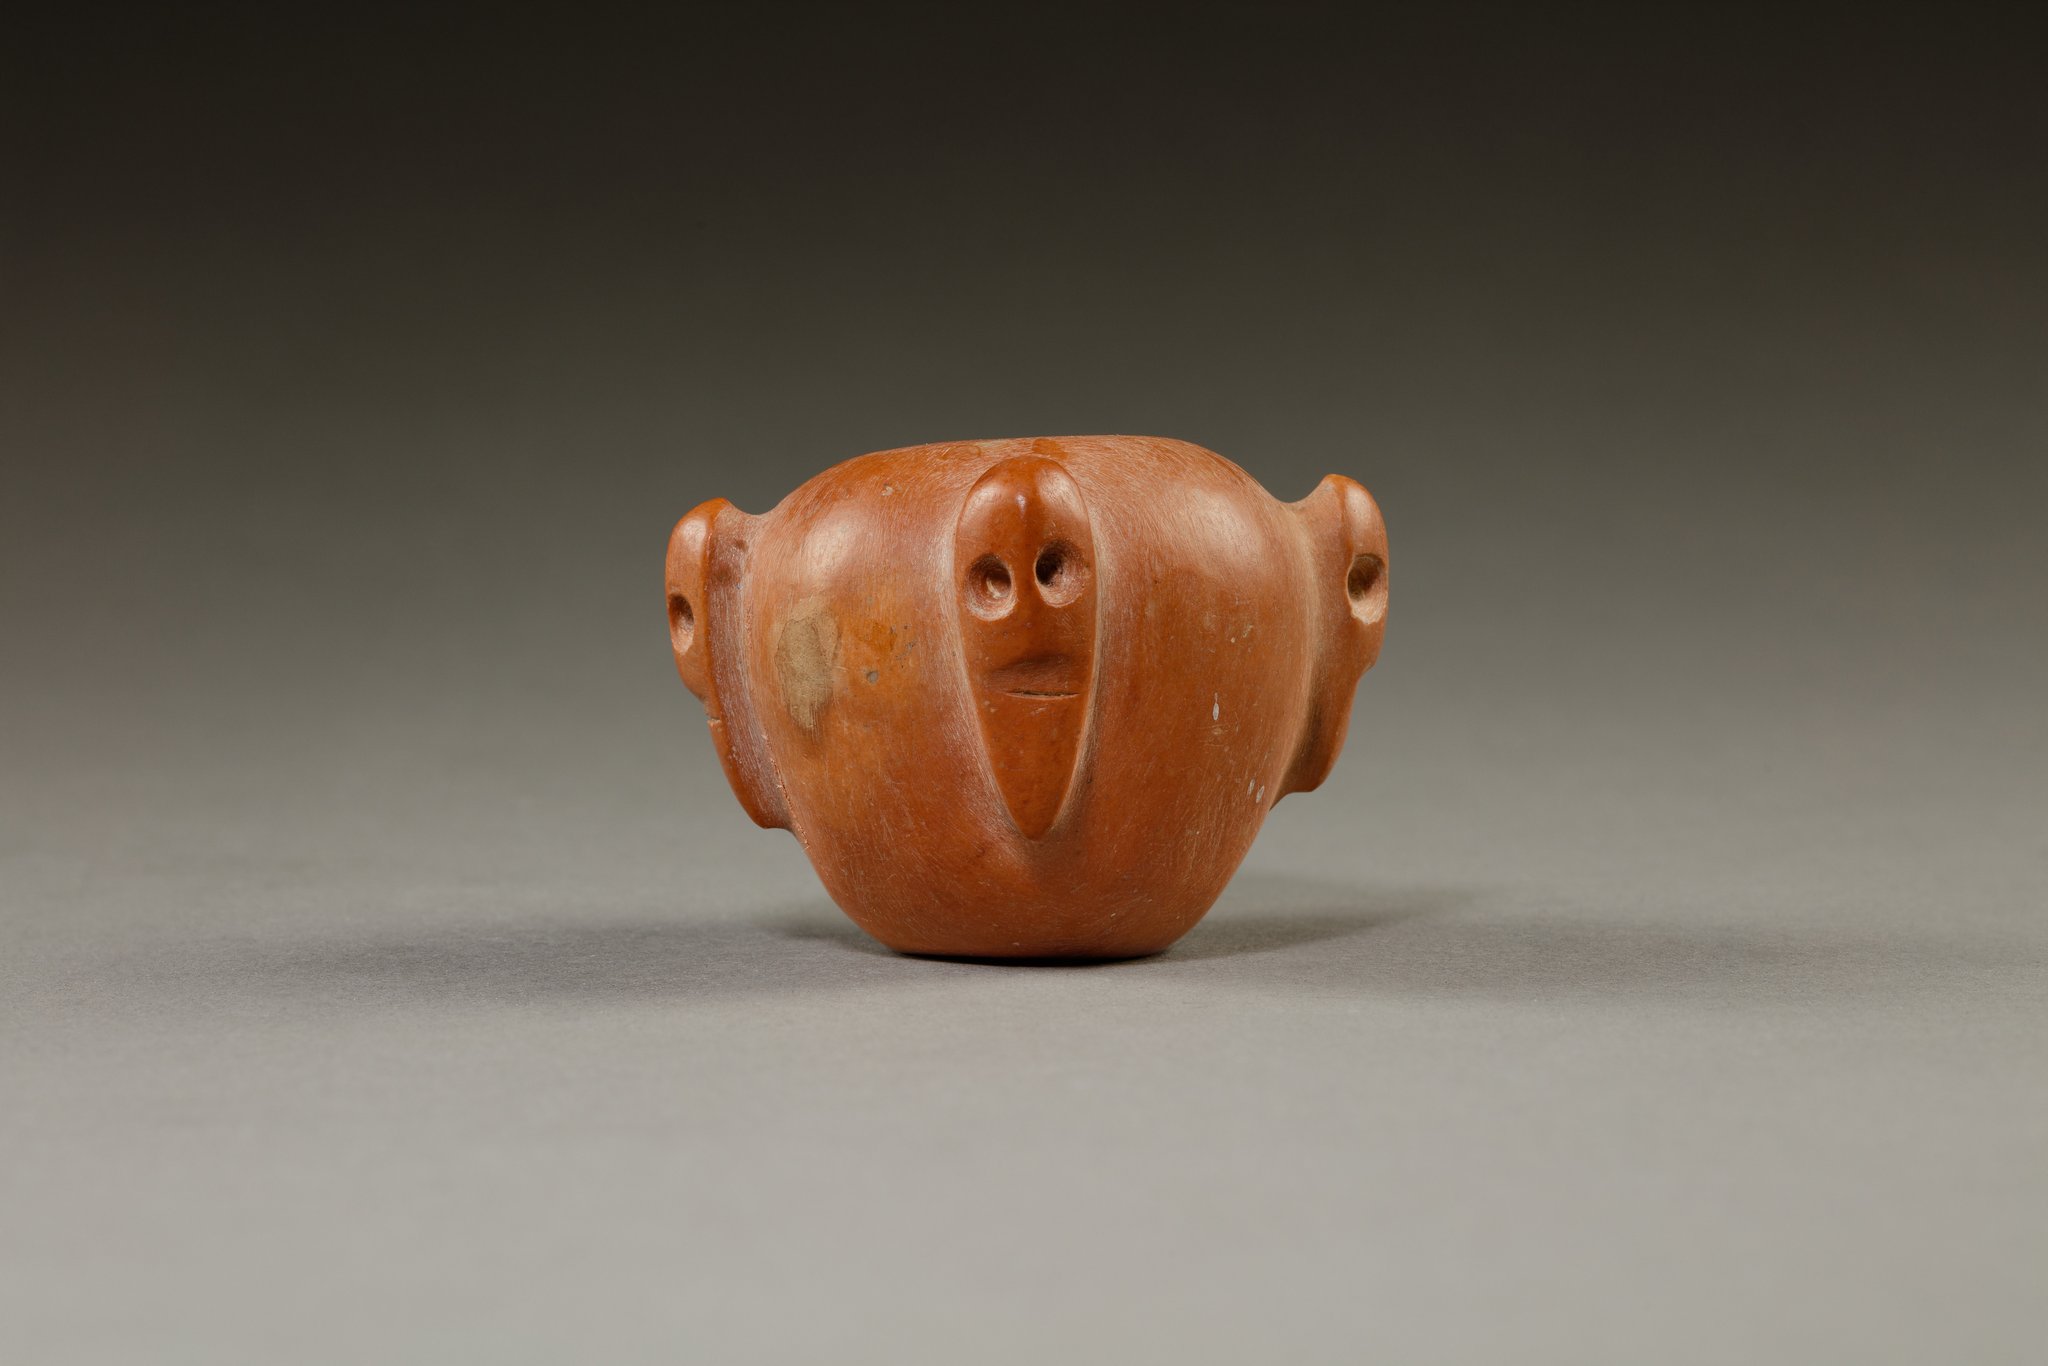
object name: macehead, piriform, face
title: Piriform macehead with male faces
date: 3650-3100 BCE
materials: limestone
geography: egypt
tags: faces